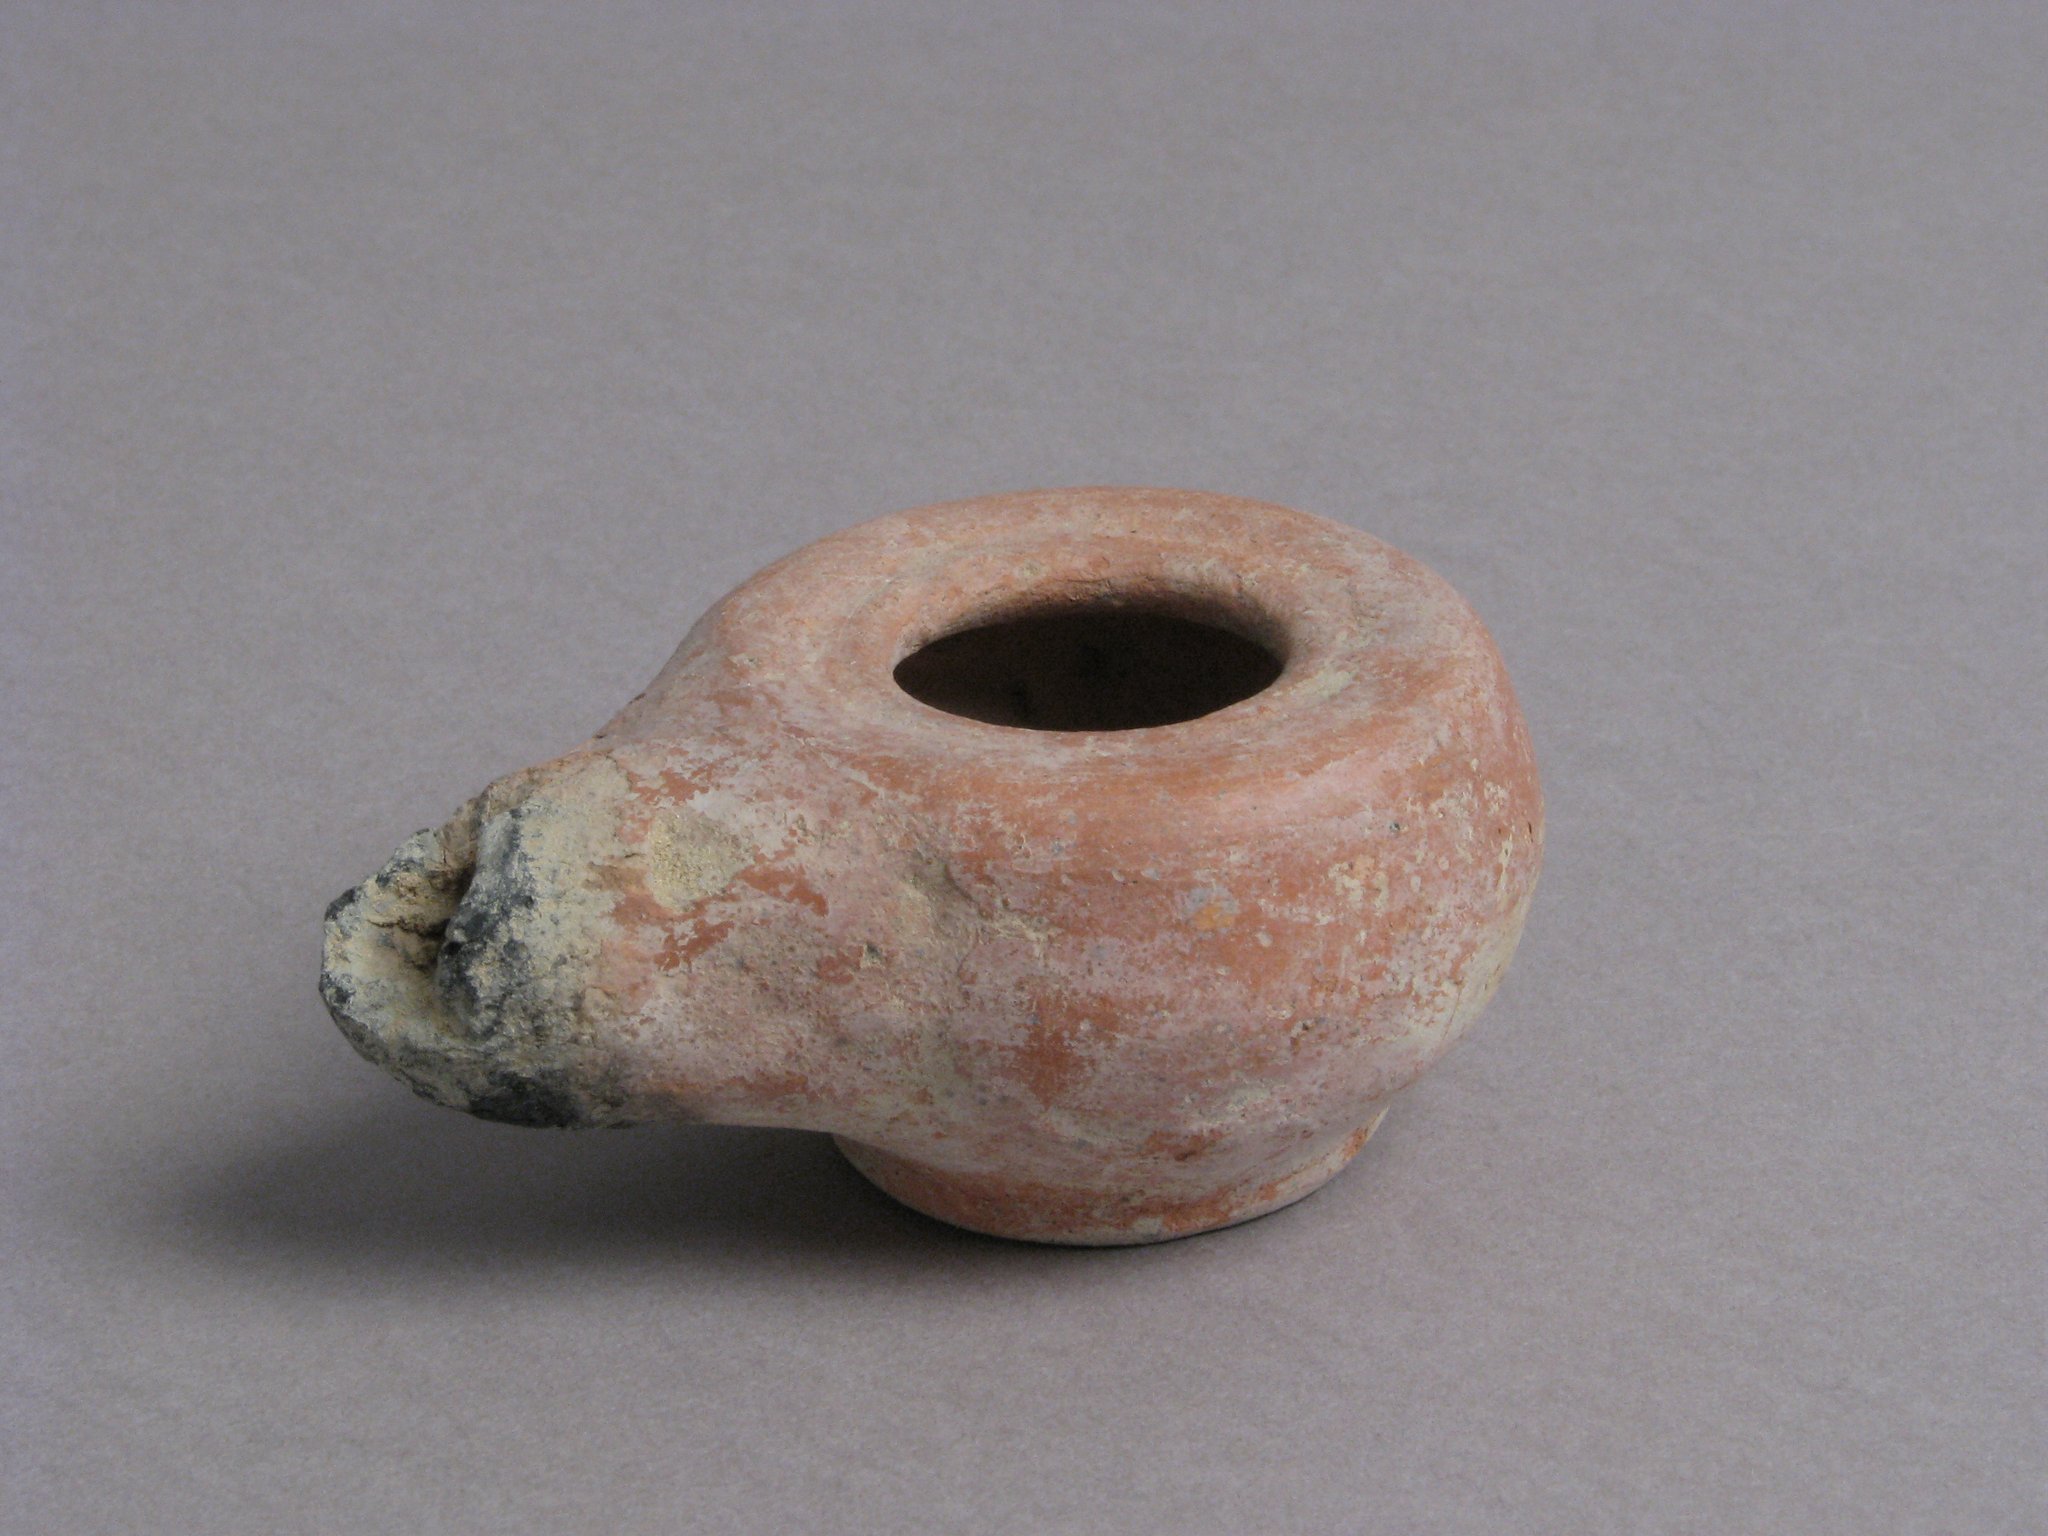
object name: lamp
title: Oil Lamp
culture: coptic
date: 301-700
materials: earthenware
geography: egypt